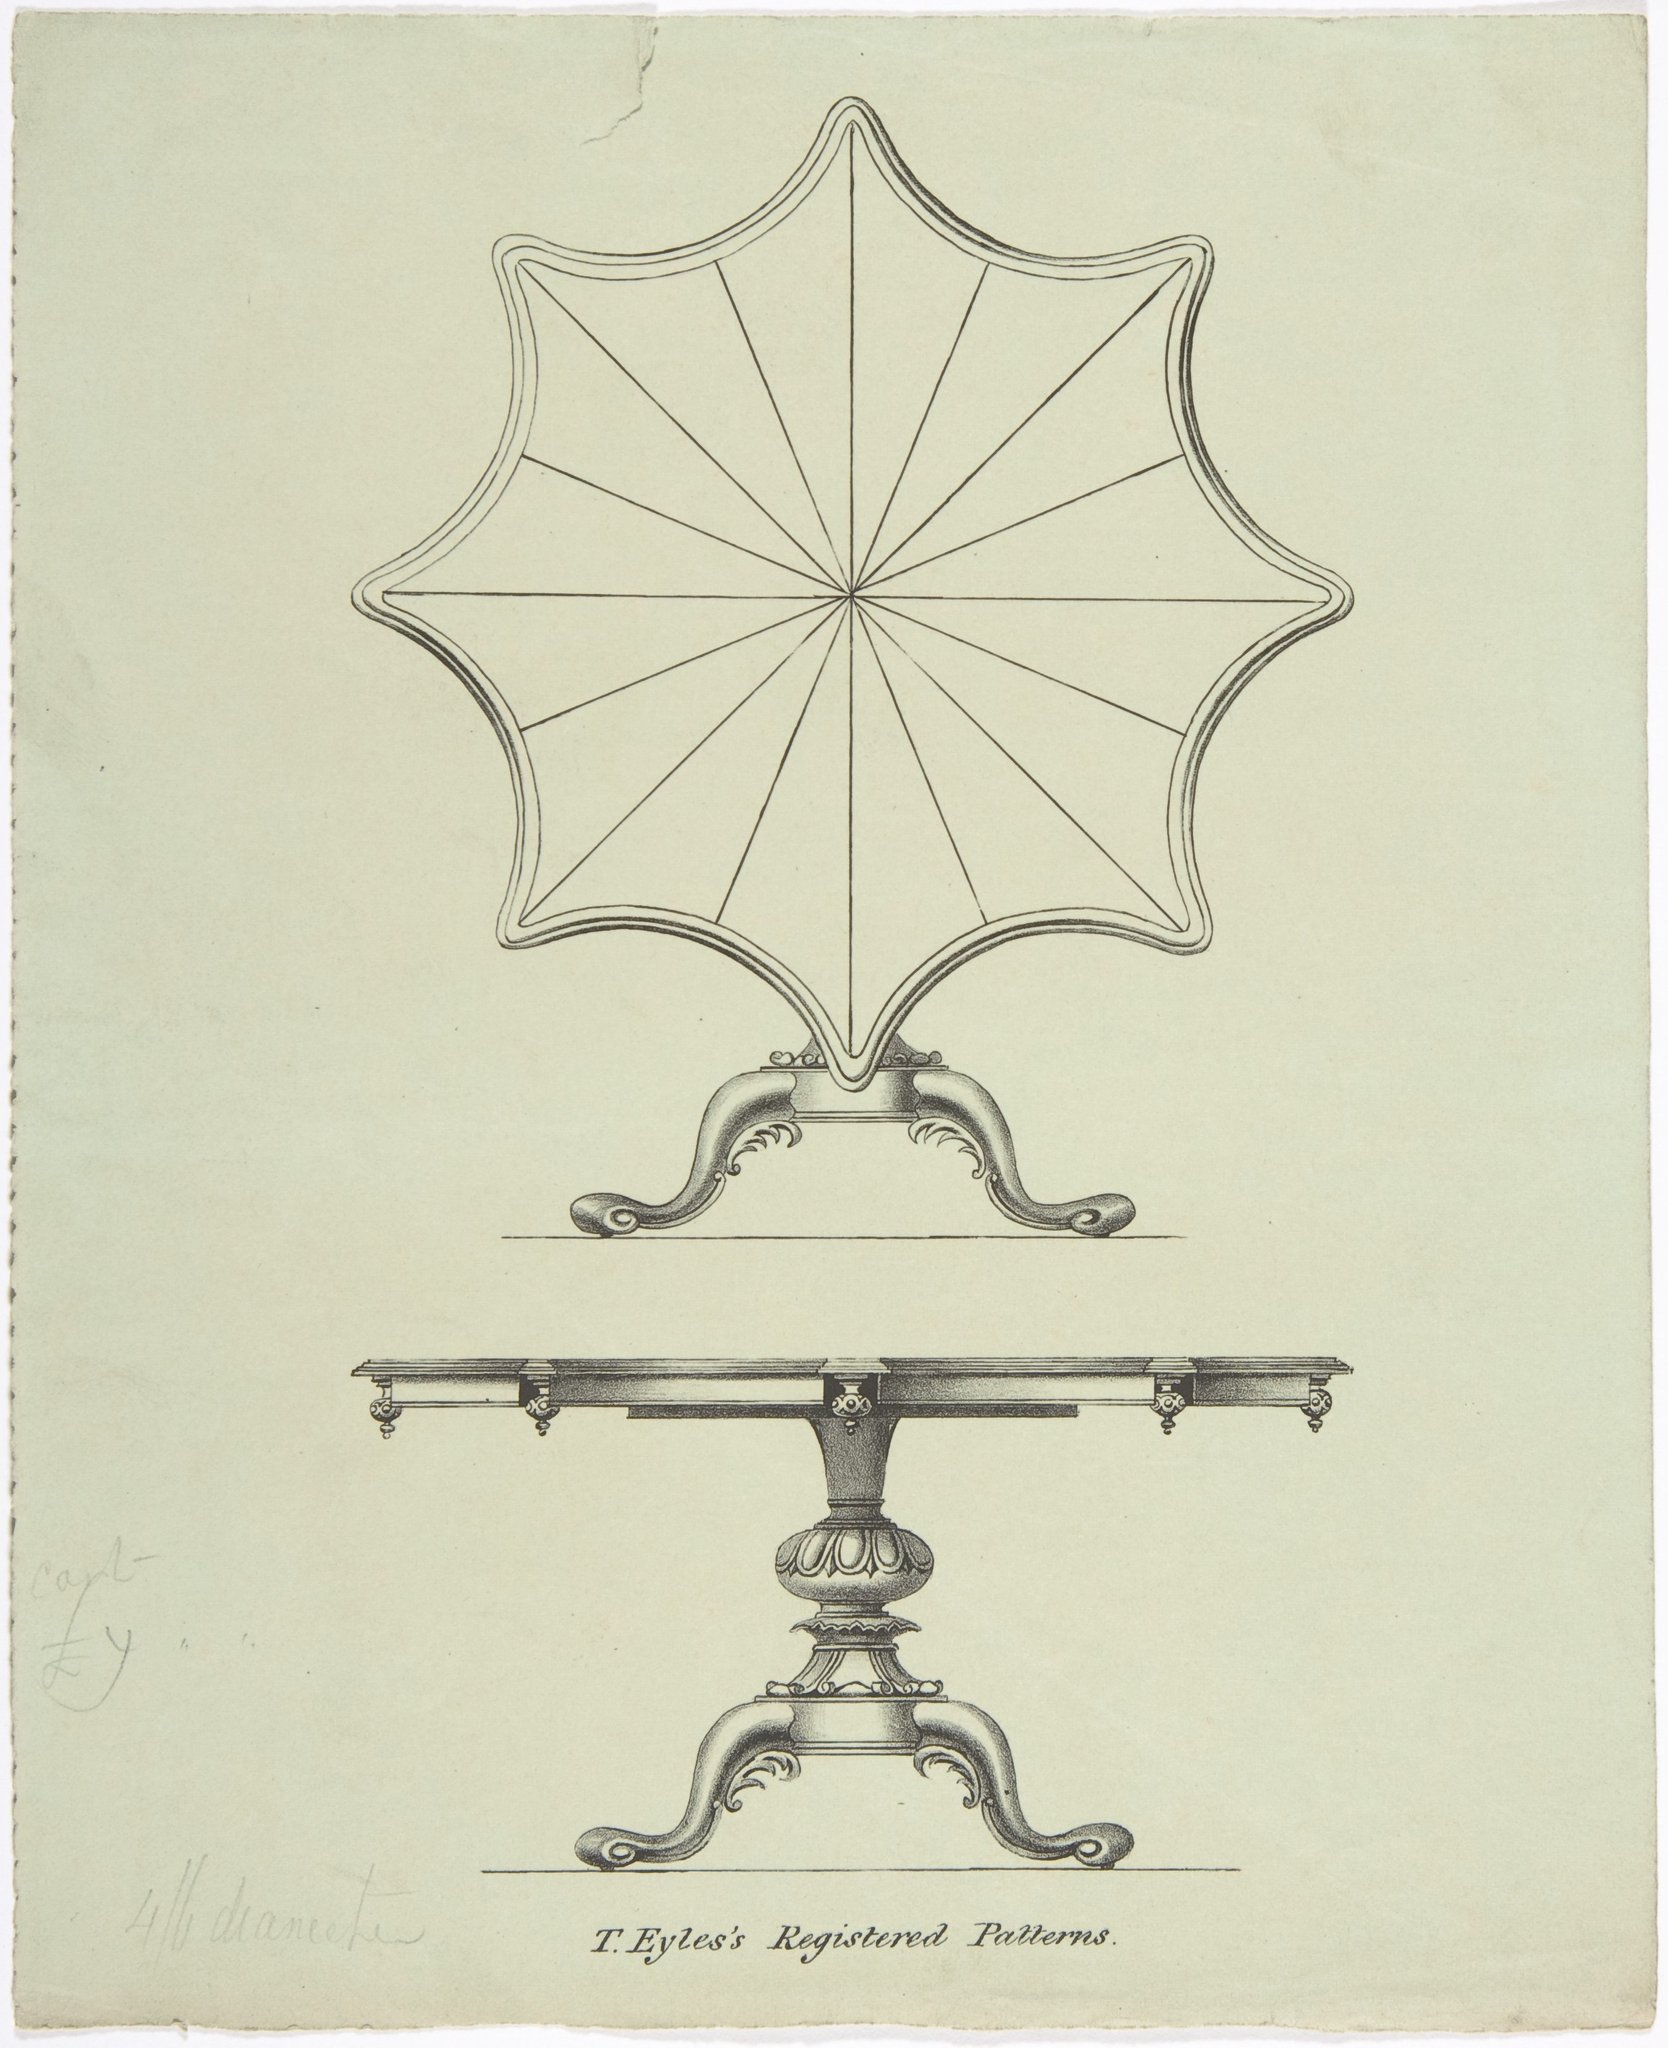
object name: drawing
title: Design for a Star-shaped Tilting Pedestal Table: Two Views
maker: anonymous, british, 19th century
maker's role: artist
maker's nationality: british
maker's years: 1800-1900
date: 1830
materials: ink, paper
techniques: pen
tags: tables